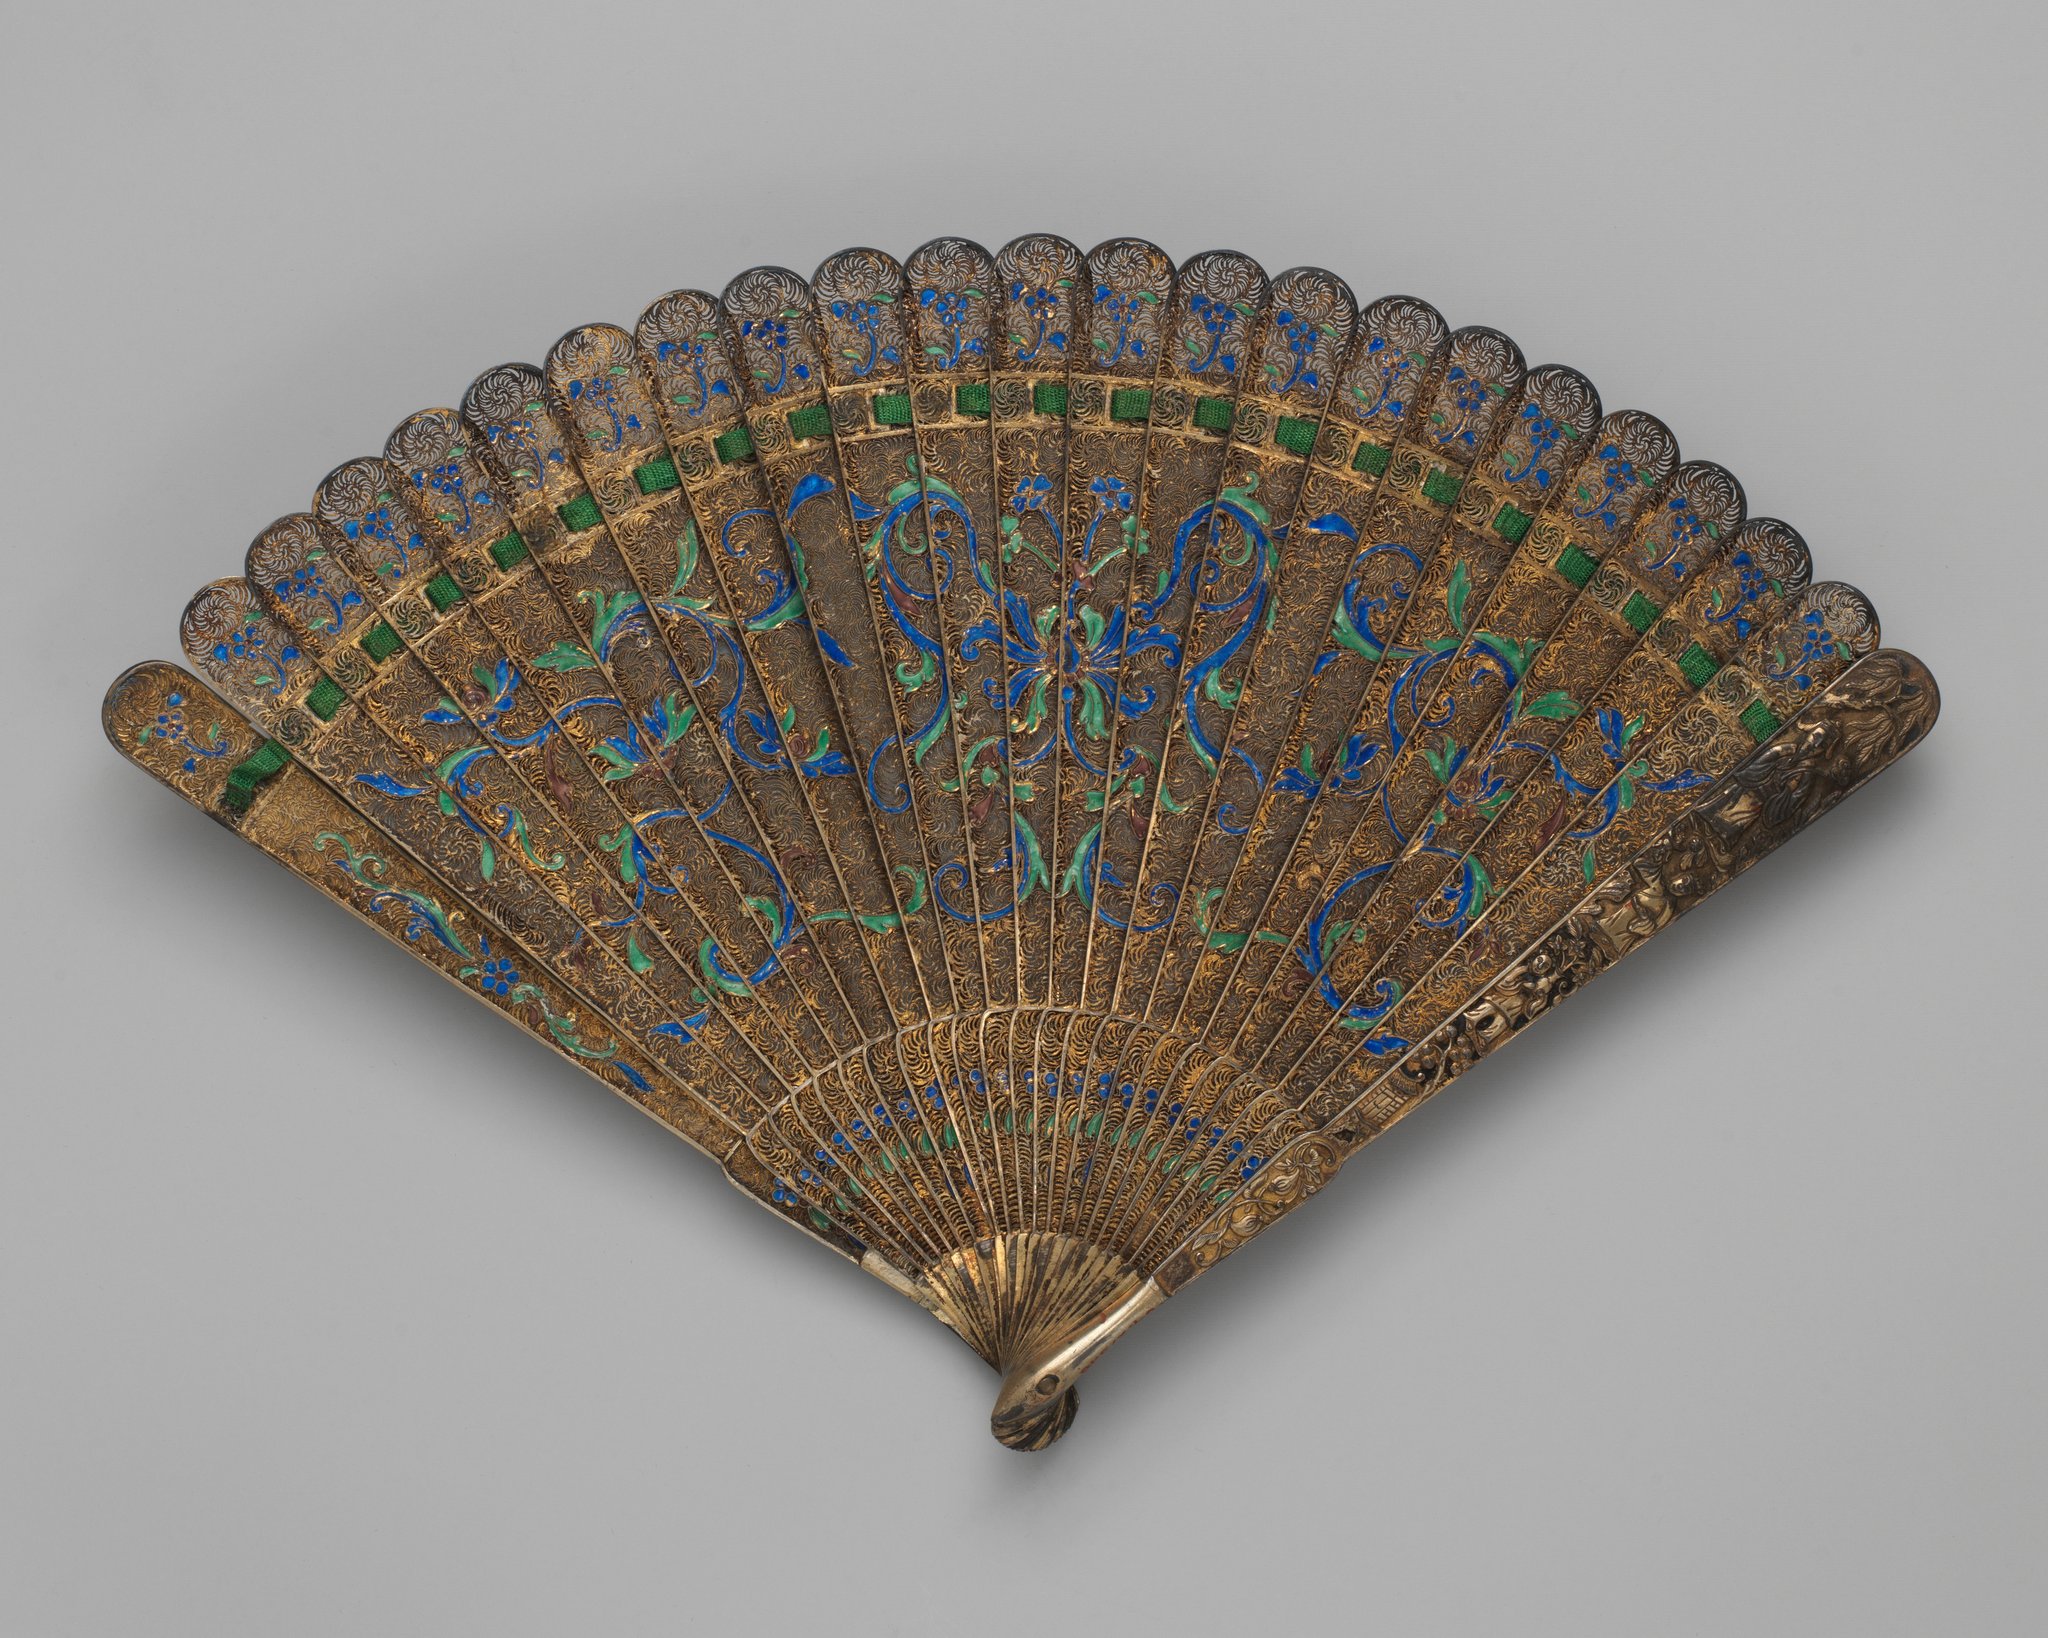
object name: fan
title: Brisé Fan, with scrolling decoration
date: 1801-1900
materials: enamel, silver gilt